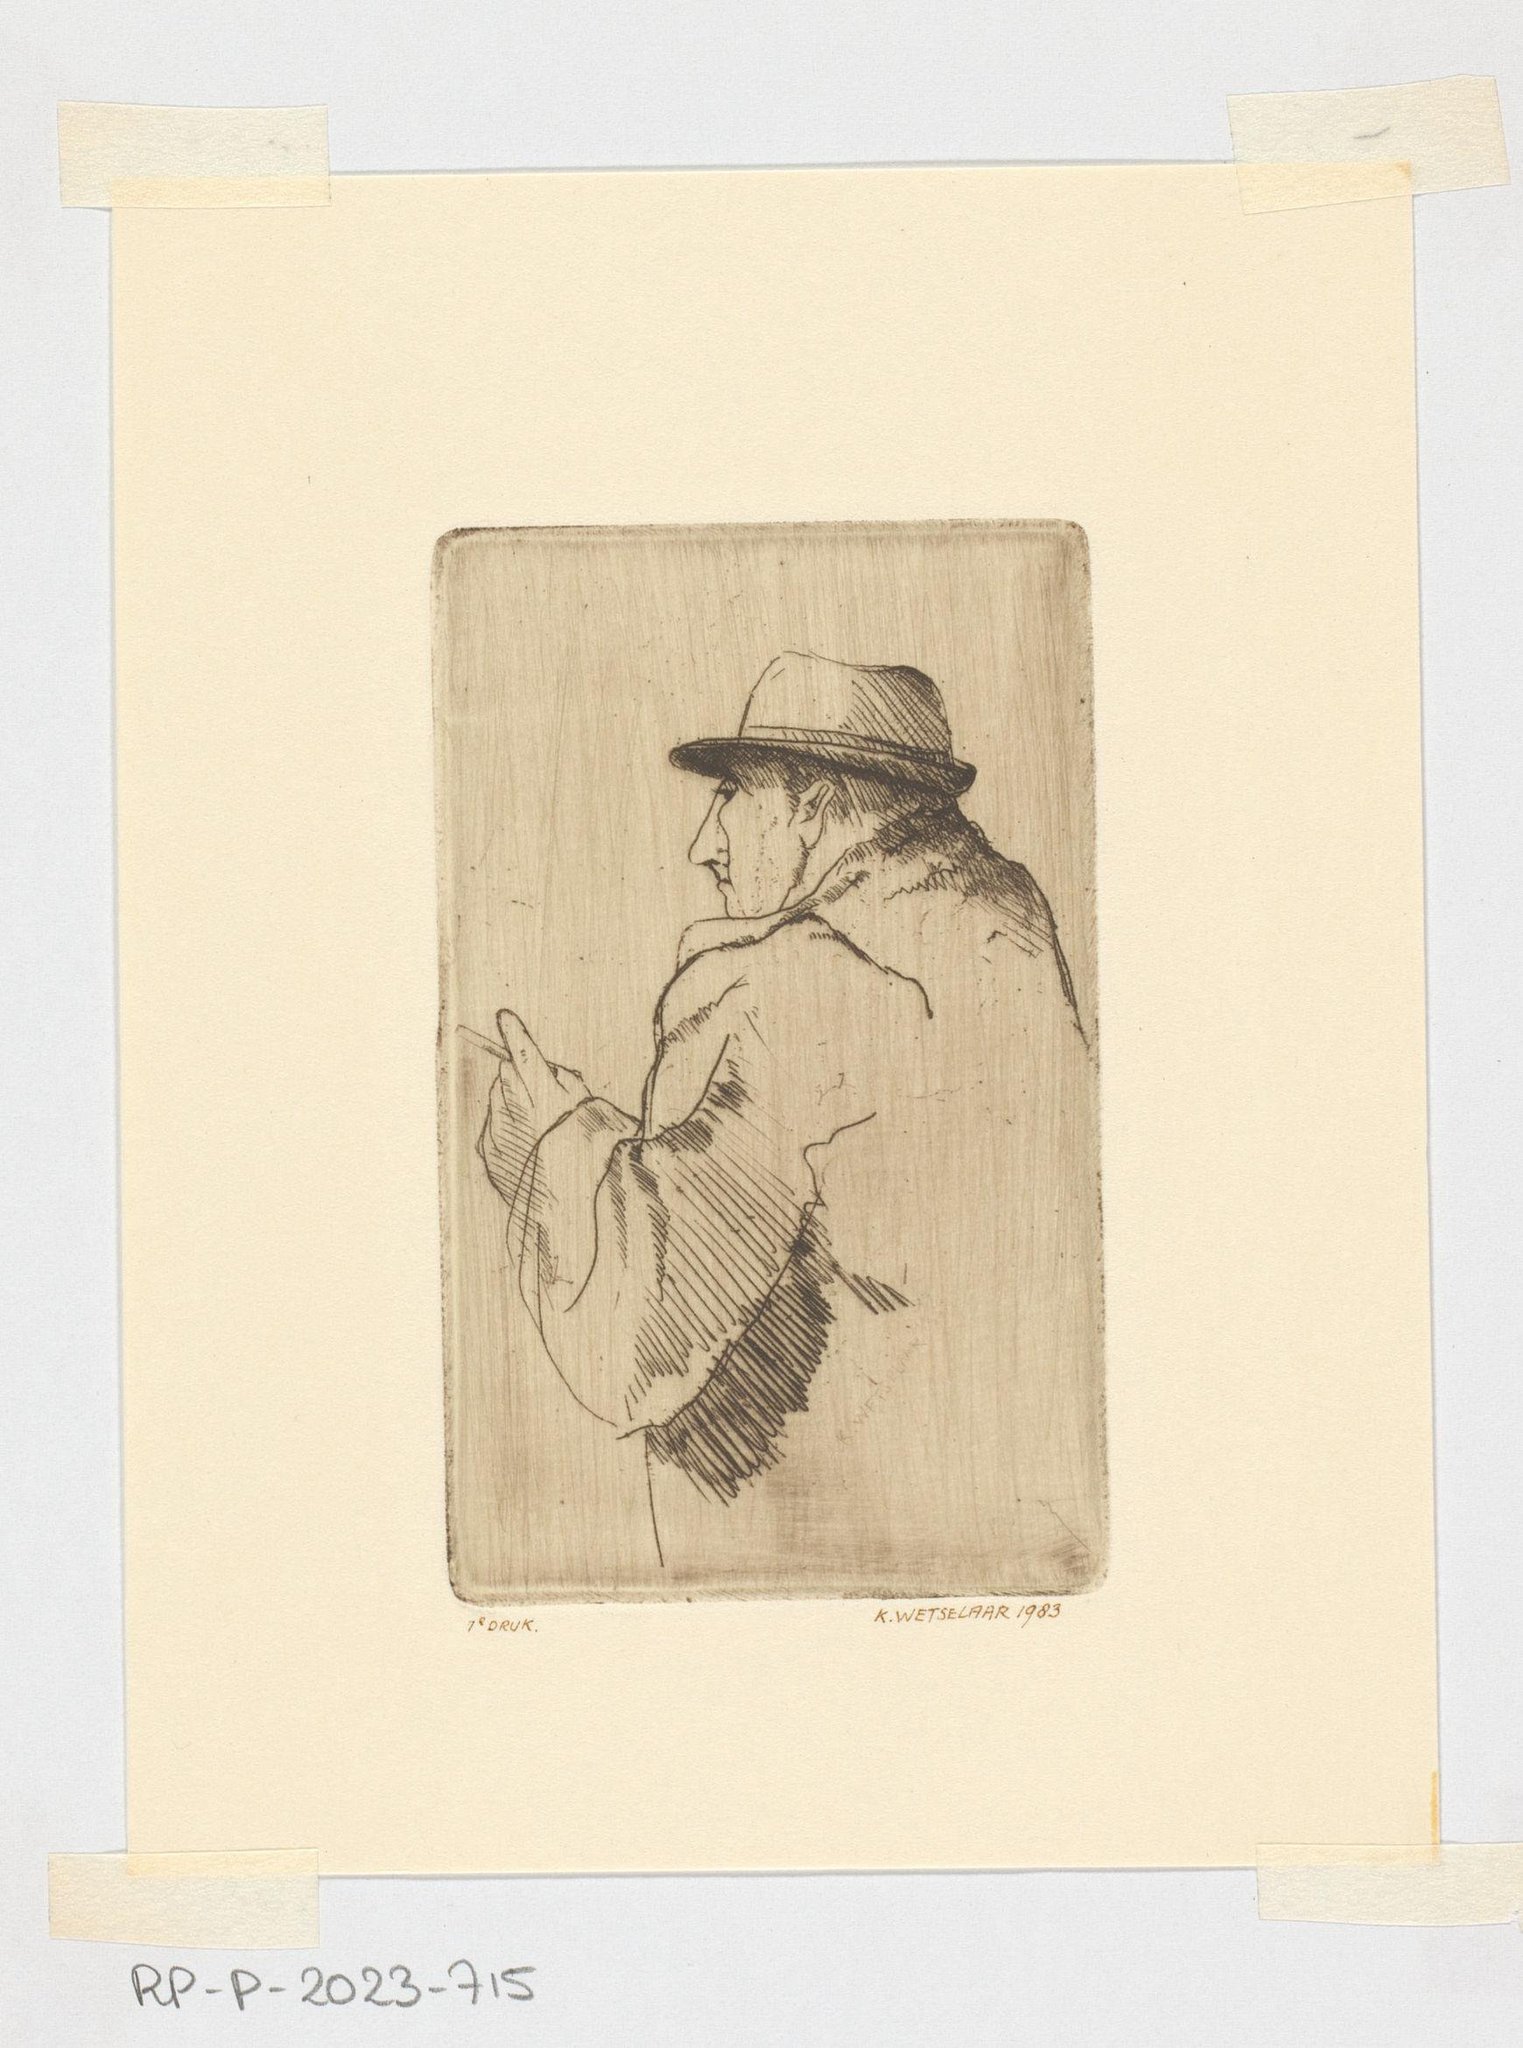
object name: print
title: Portret van een onbekende man met hoed en sigaret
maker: karel wetselaar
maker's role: print maker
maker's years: 1935-2017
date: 1983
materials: paper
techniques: etching, intaglio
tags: cigarette, historical persons not known by name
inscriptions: signature and date: ‘K. Wetselaar 1983’, inscription: ‘1e druk’